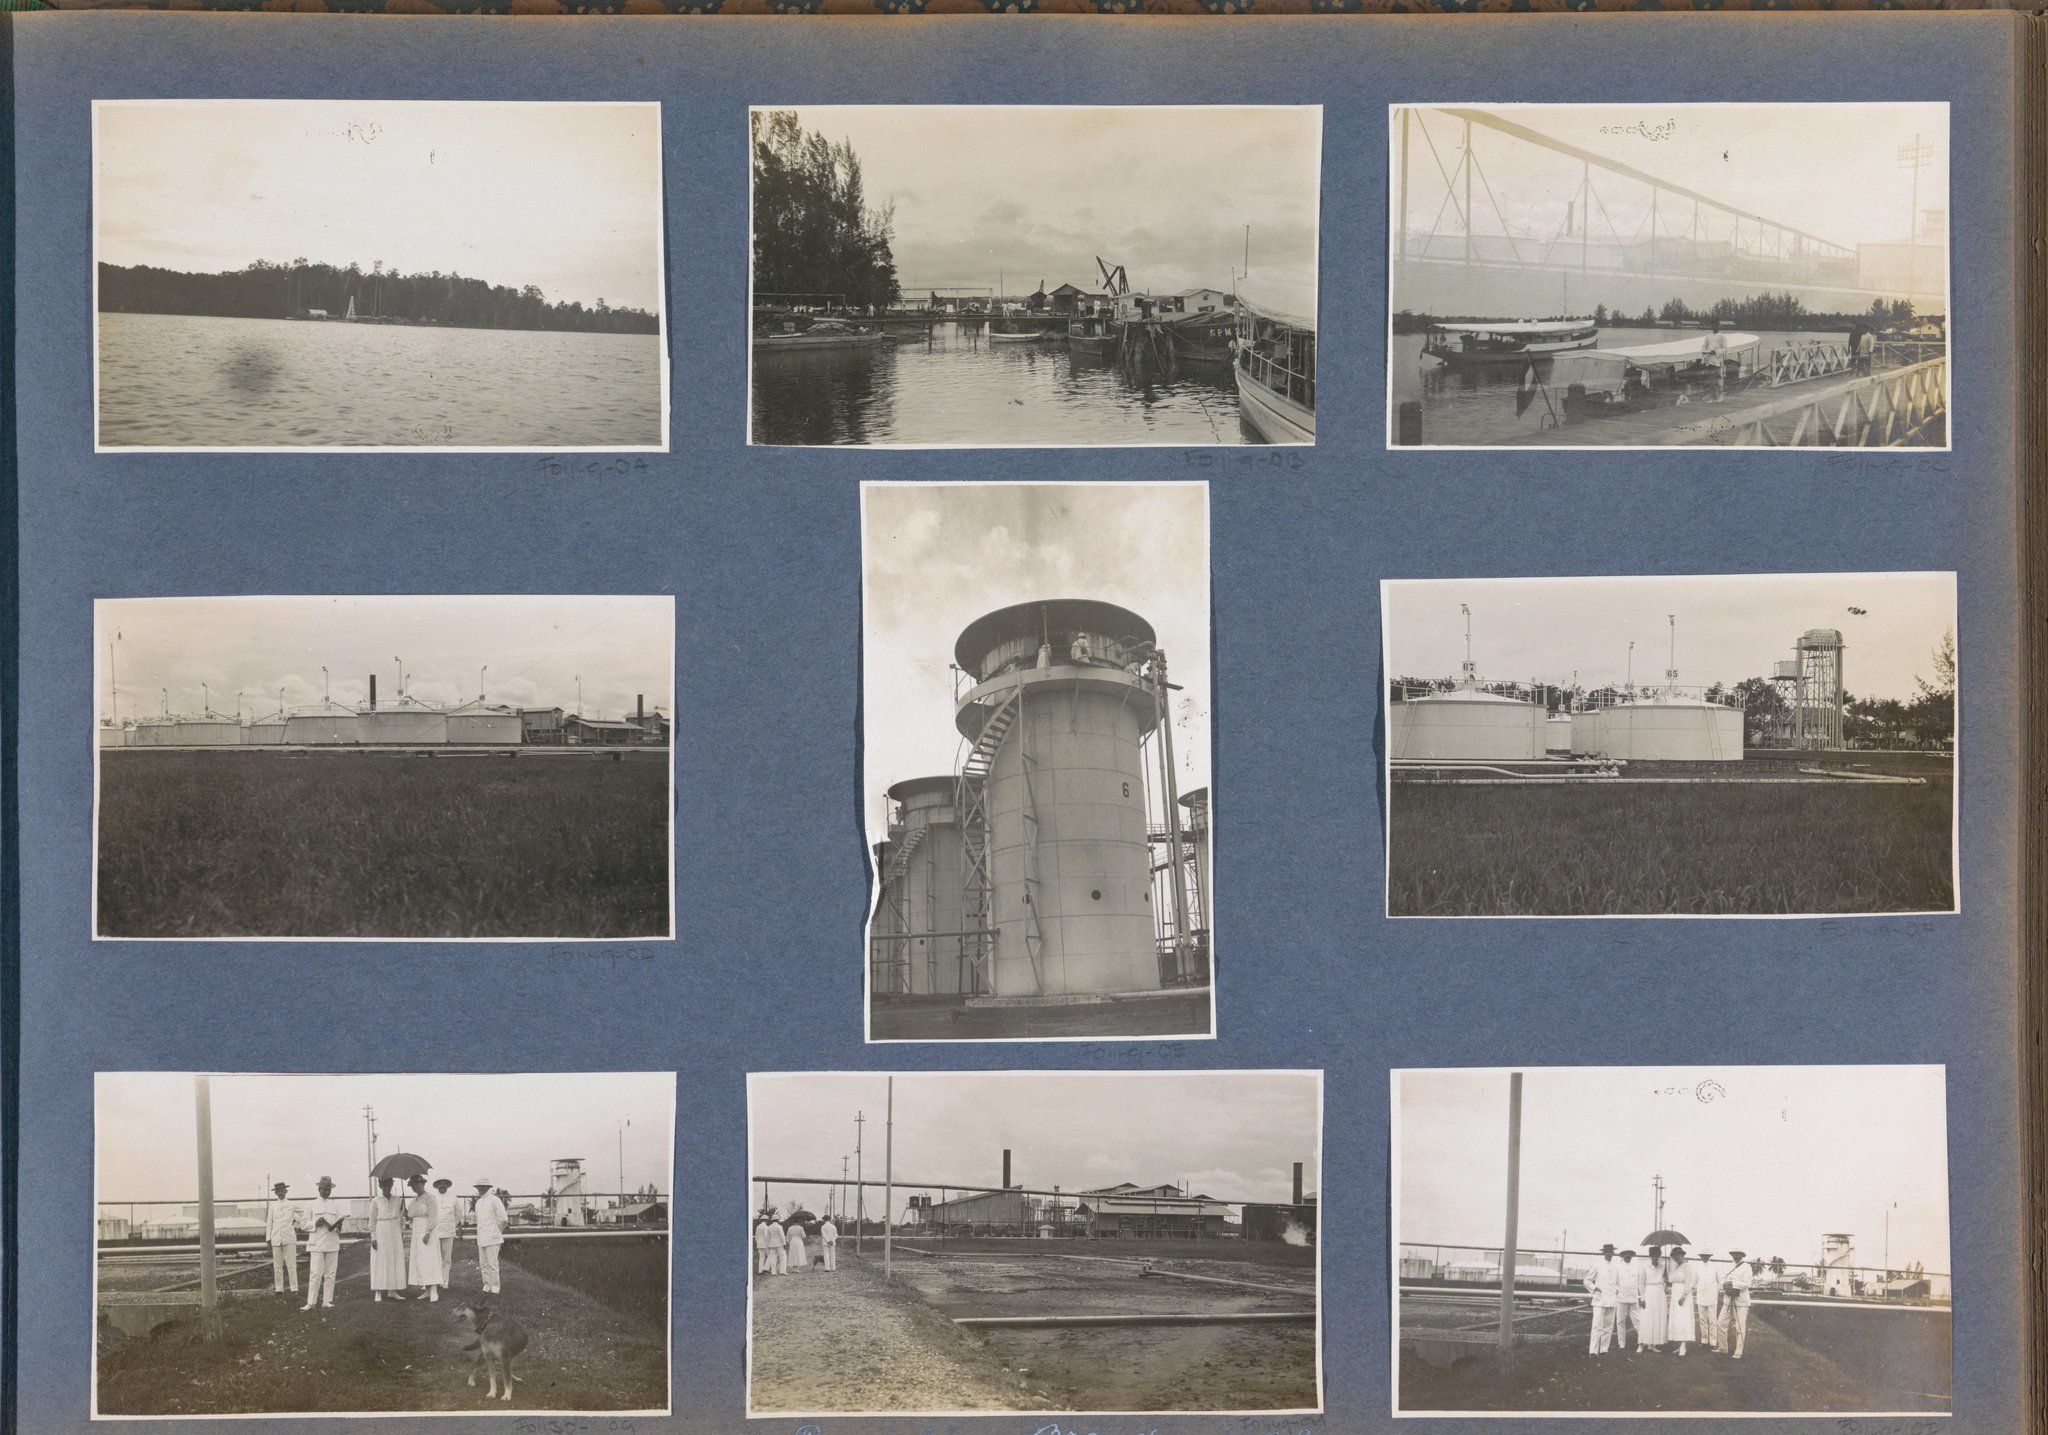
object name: album leaf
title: Fabriekscomplex met olietanks te Pangkalang-Brandan op Sumatra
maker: Anonymous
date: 1900-1920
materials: paper, photographic support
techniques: gelatin silver print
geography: sumatra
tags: oil tanks, oil; oil refinery, sumatra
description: Onderdeel van reisalbum met foto's van bedrijvigheid en bezienswaardigheden op Sumatra en Java en van de reis naar en van Nederlands-Indië.